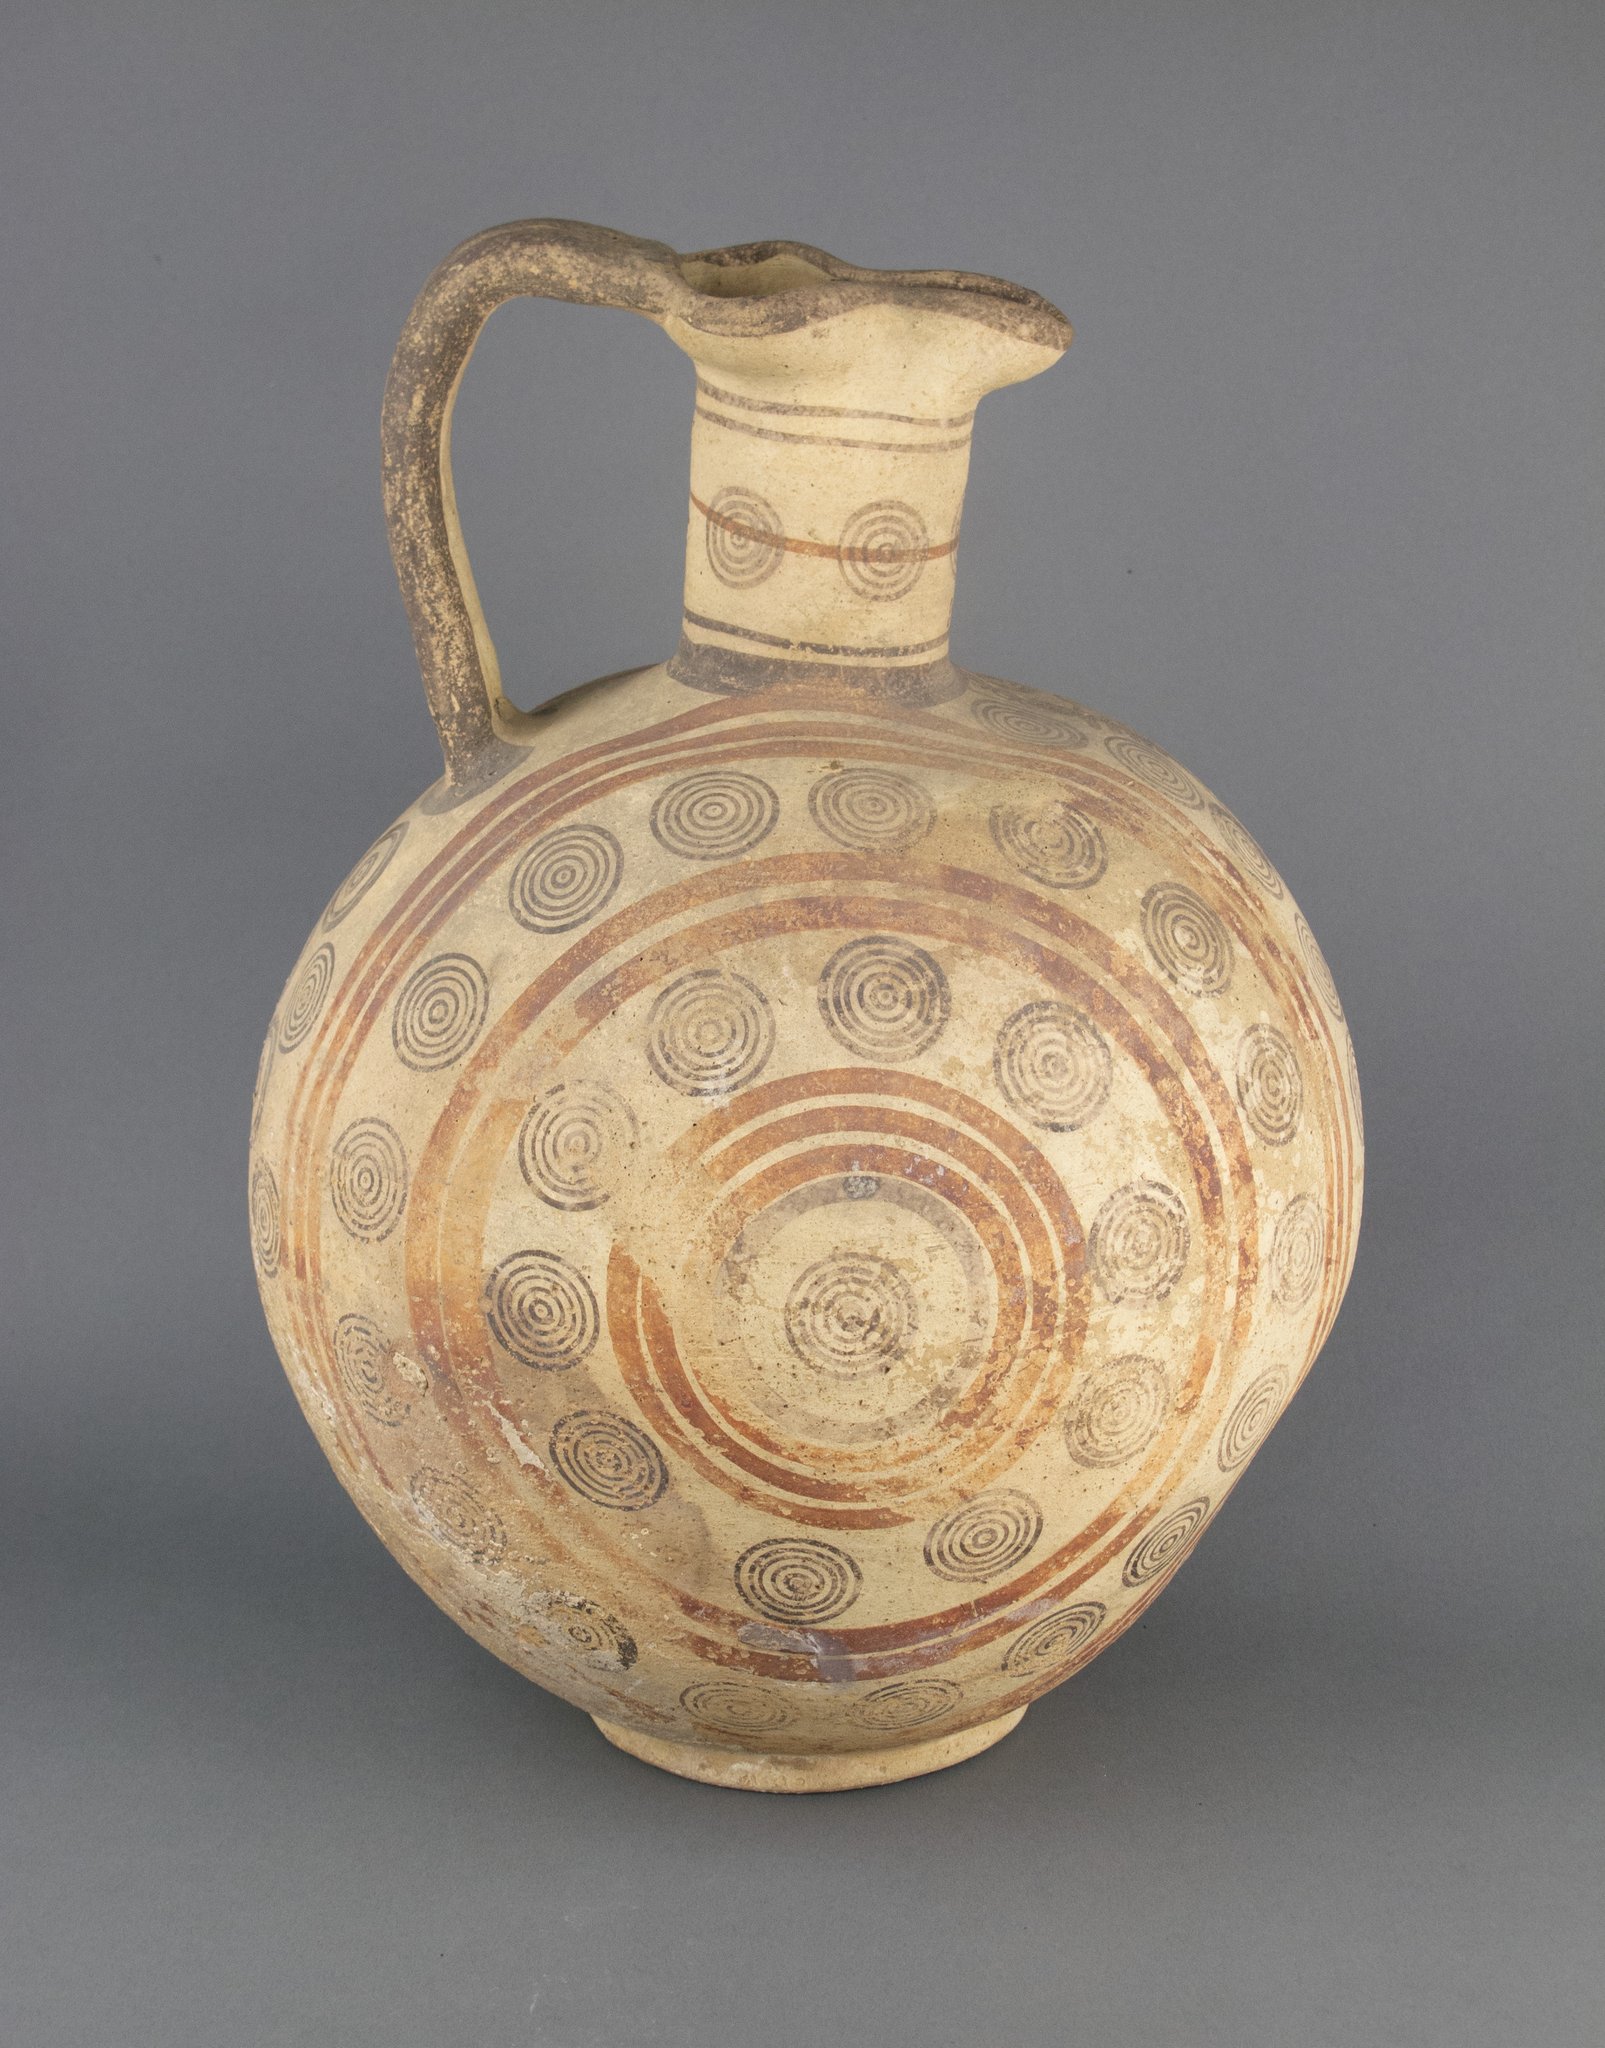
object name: jug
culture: cypriot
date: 750-600 BCE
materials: terracotta